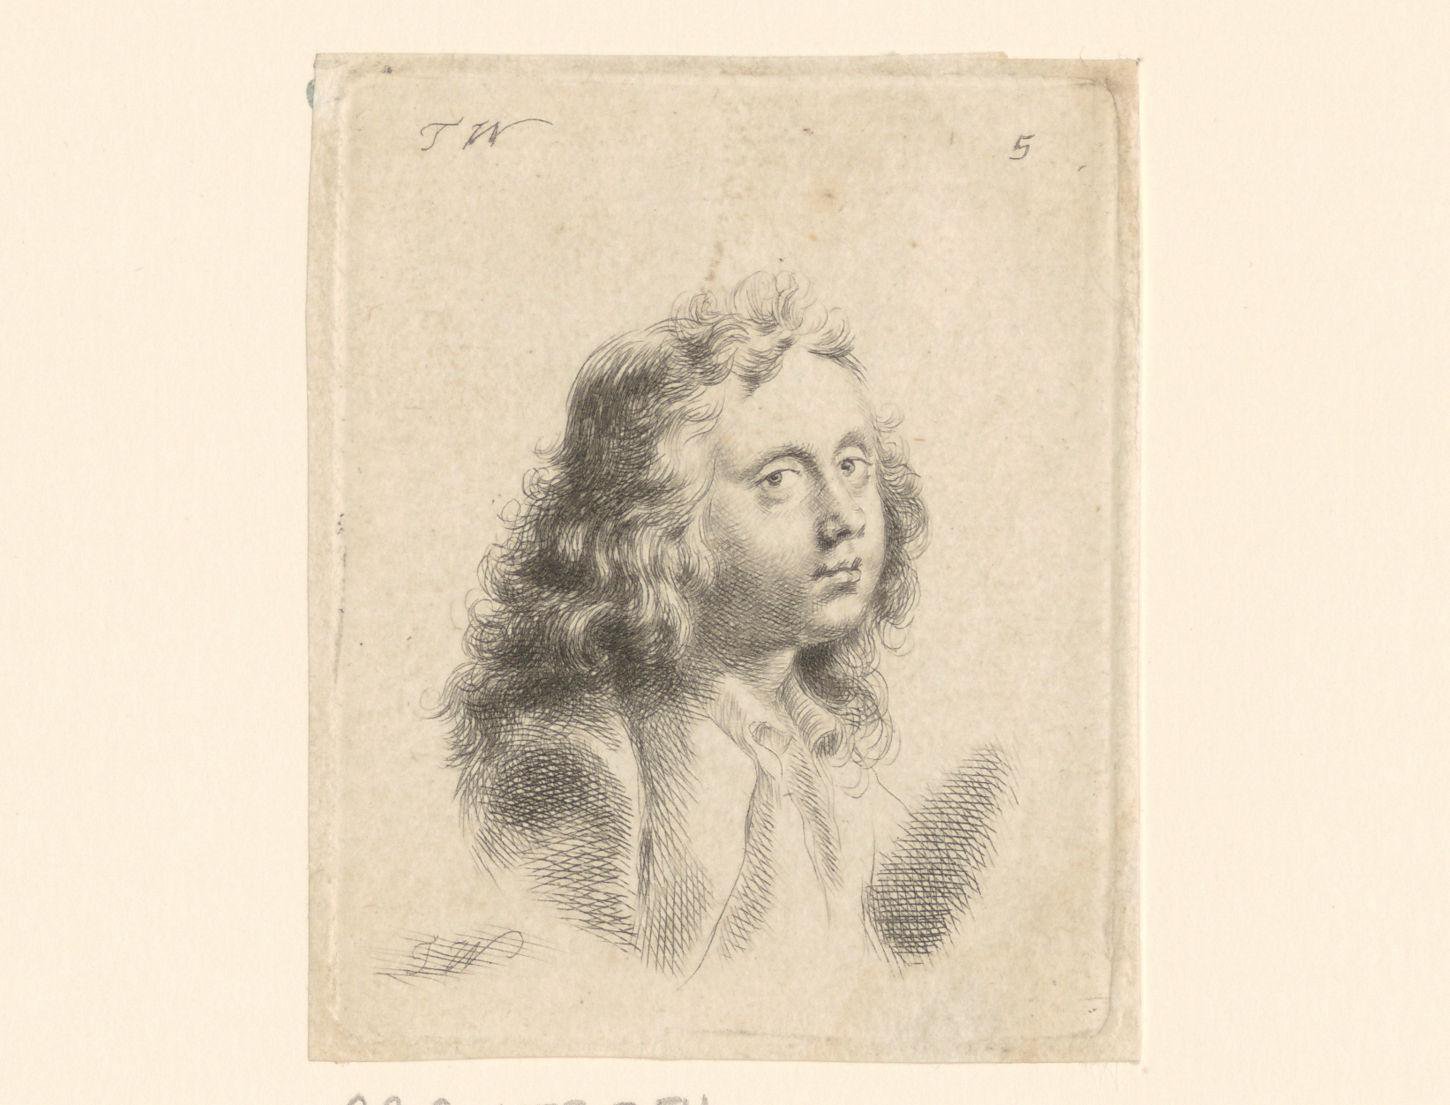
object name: print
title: Portret van William Kenrick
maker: thomas worlidge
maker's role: print maker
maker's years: 1700-1766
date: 1766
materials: paper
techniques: etching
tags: historical persons, portrait of a writer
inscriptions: collector's mark: Lugt 2228, collector's mark: Lugt 2760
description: Nummer 5 in de catalogus van Worlidges prenten die zijn weduwe in 1767, na het overlijden van Worlidge, opstelde.